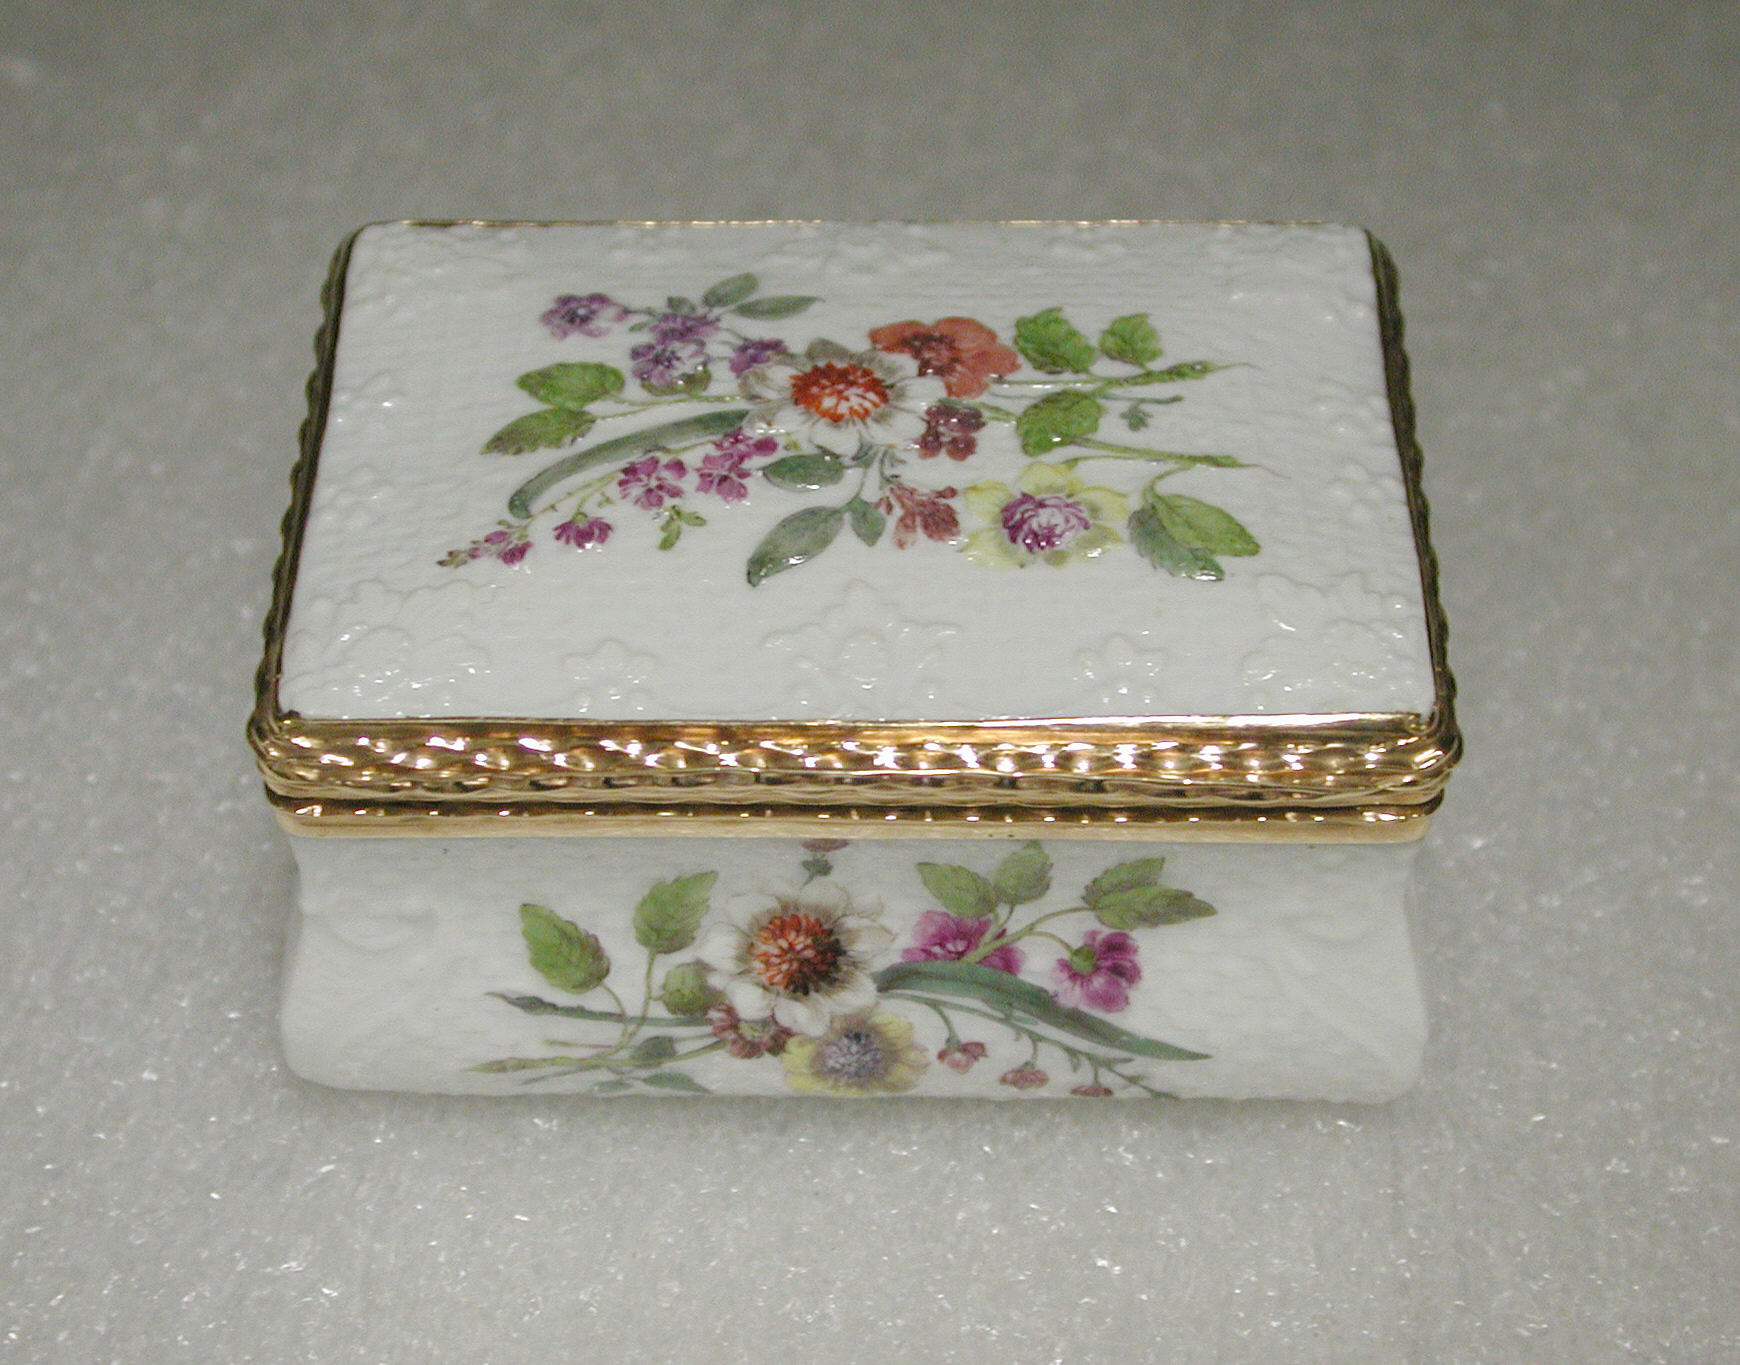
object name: snuffbox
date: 1801-1900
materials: gold, hard paste porcelain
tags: flowers